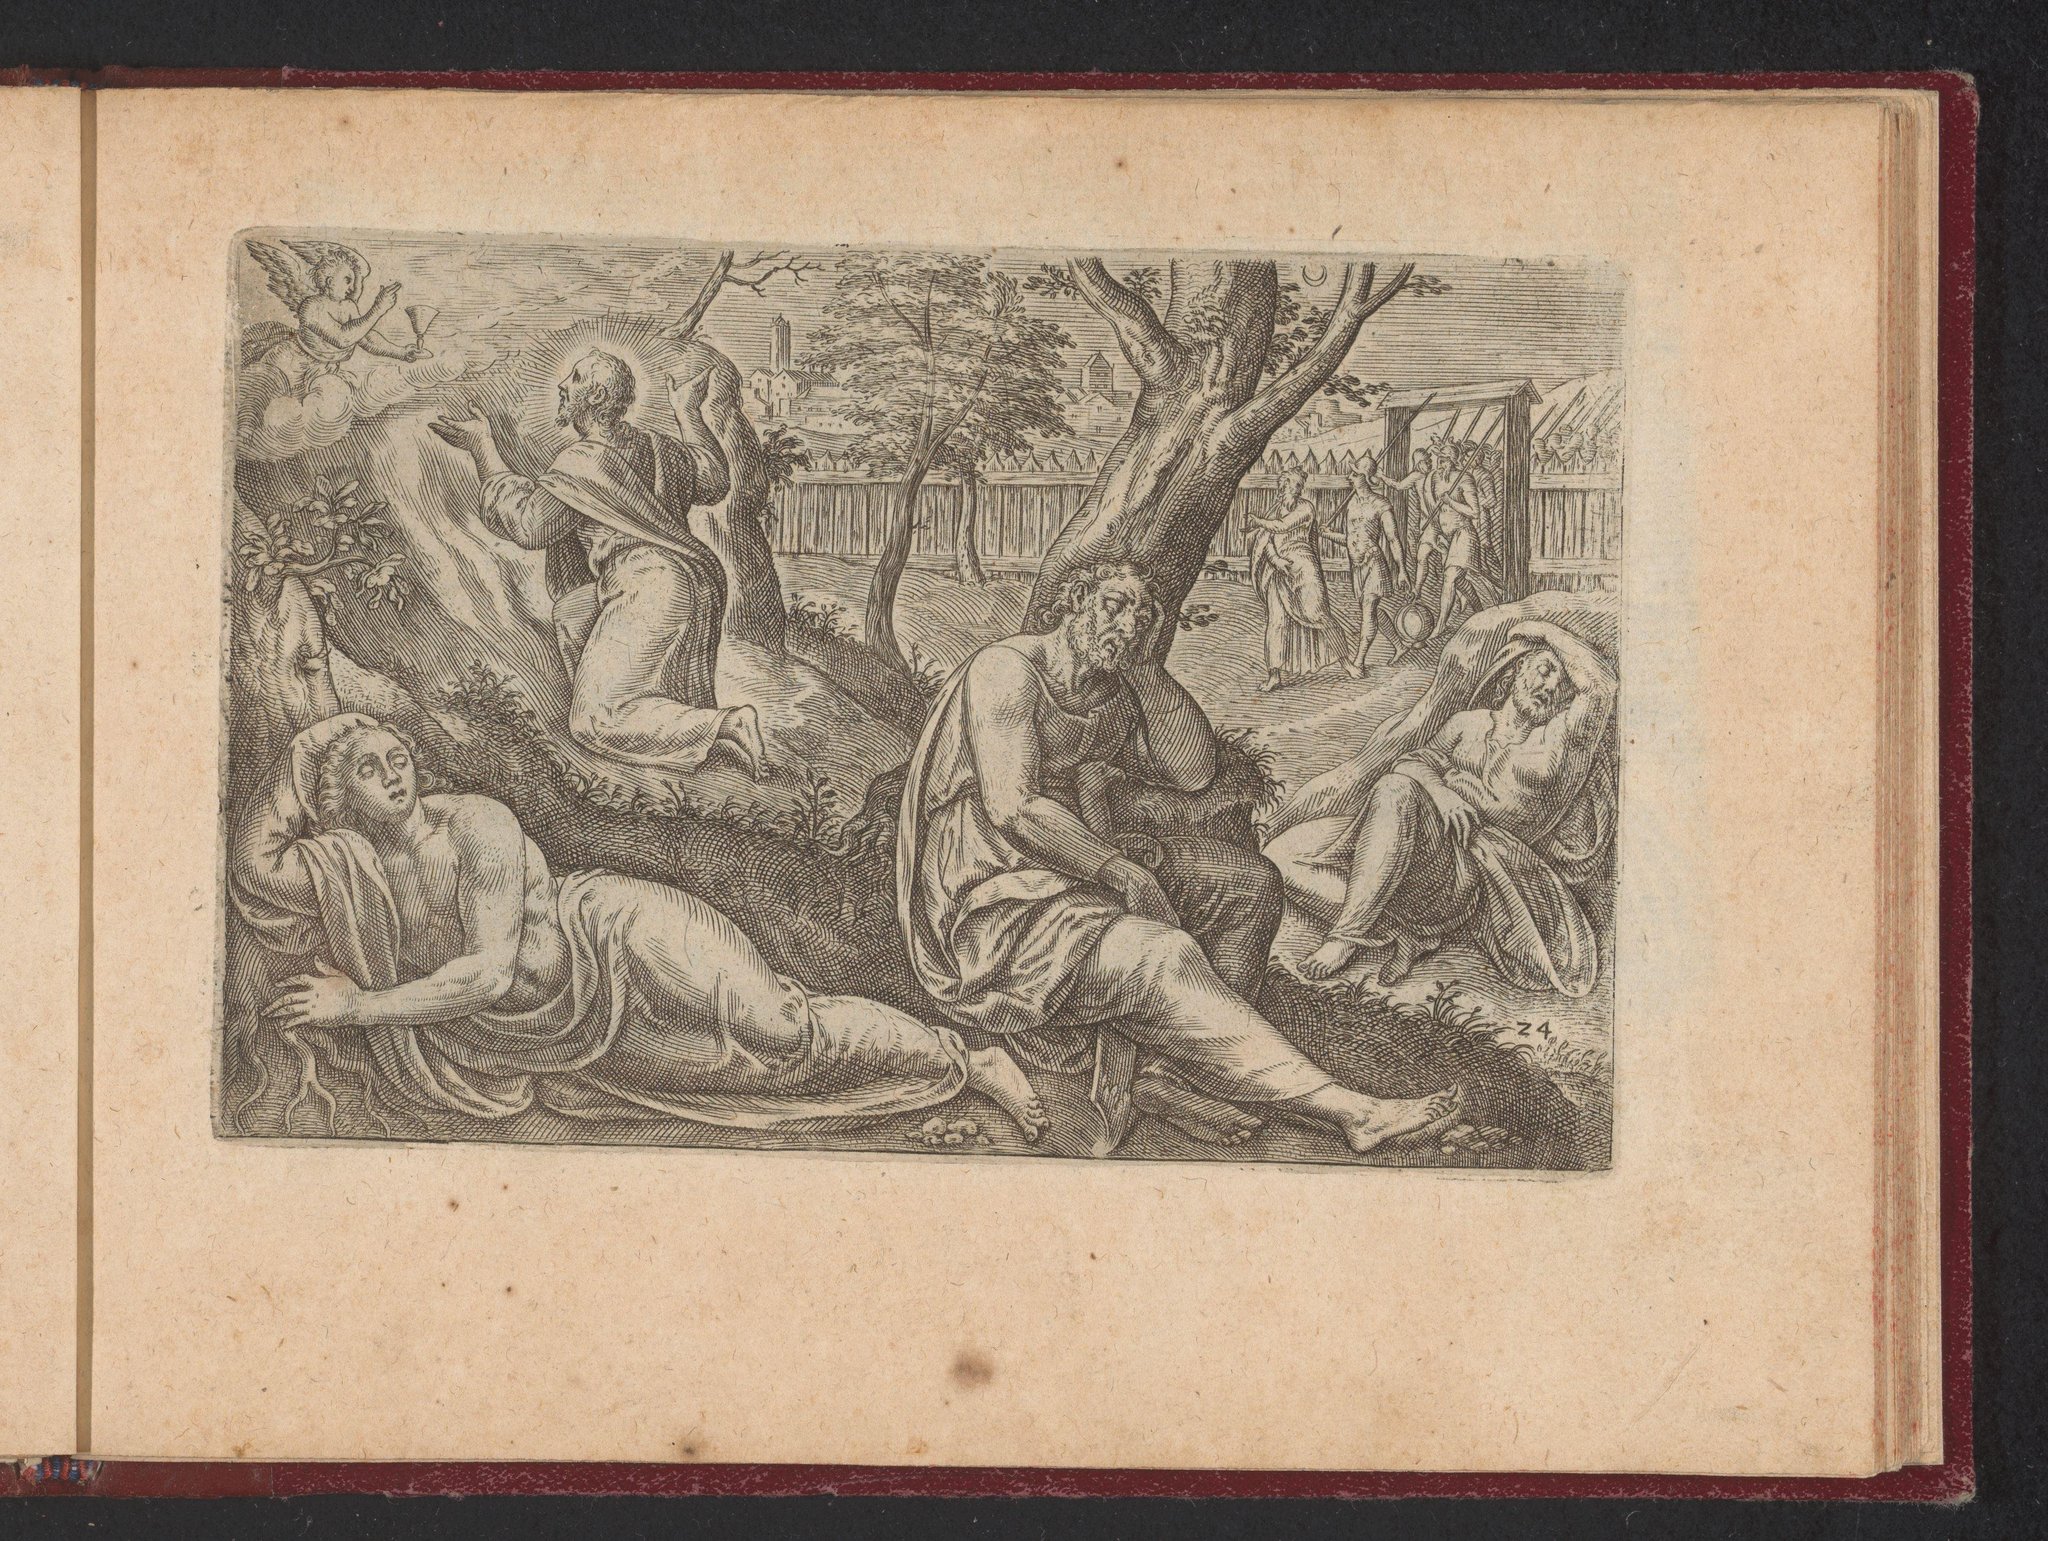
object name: print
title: Christi Iesu vitae admirabiliumque actionum speculum a Philippo Gallaeo apparatum Bened. Ariae Montani singuloribus distichis instructum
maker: philips galle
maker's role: print maker, publisher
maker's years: 1537-1612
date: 1573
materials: paper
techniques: engraving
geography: antwerp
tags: agony of christ; three (or eleven) apostles sleeping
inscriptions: watermark: ‘gotische letter P’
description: Onderdeel van een album met een titelprent en een serie van 50 prenten betreffende het leven en de passie van Christus.